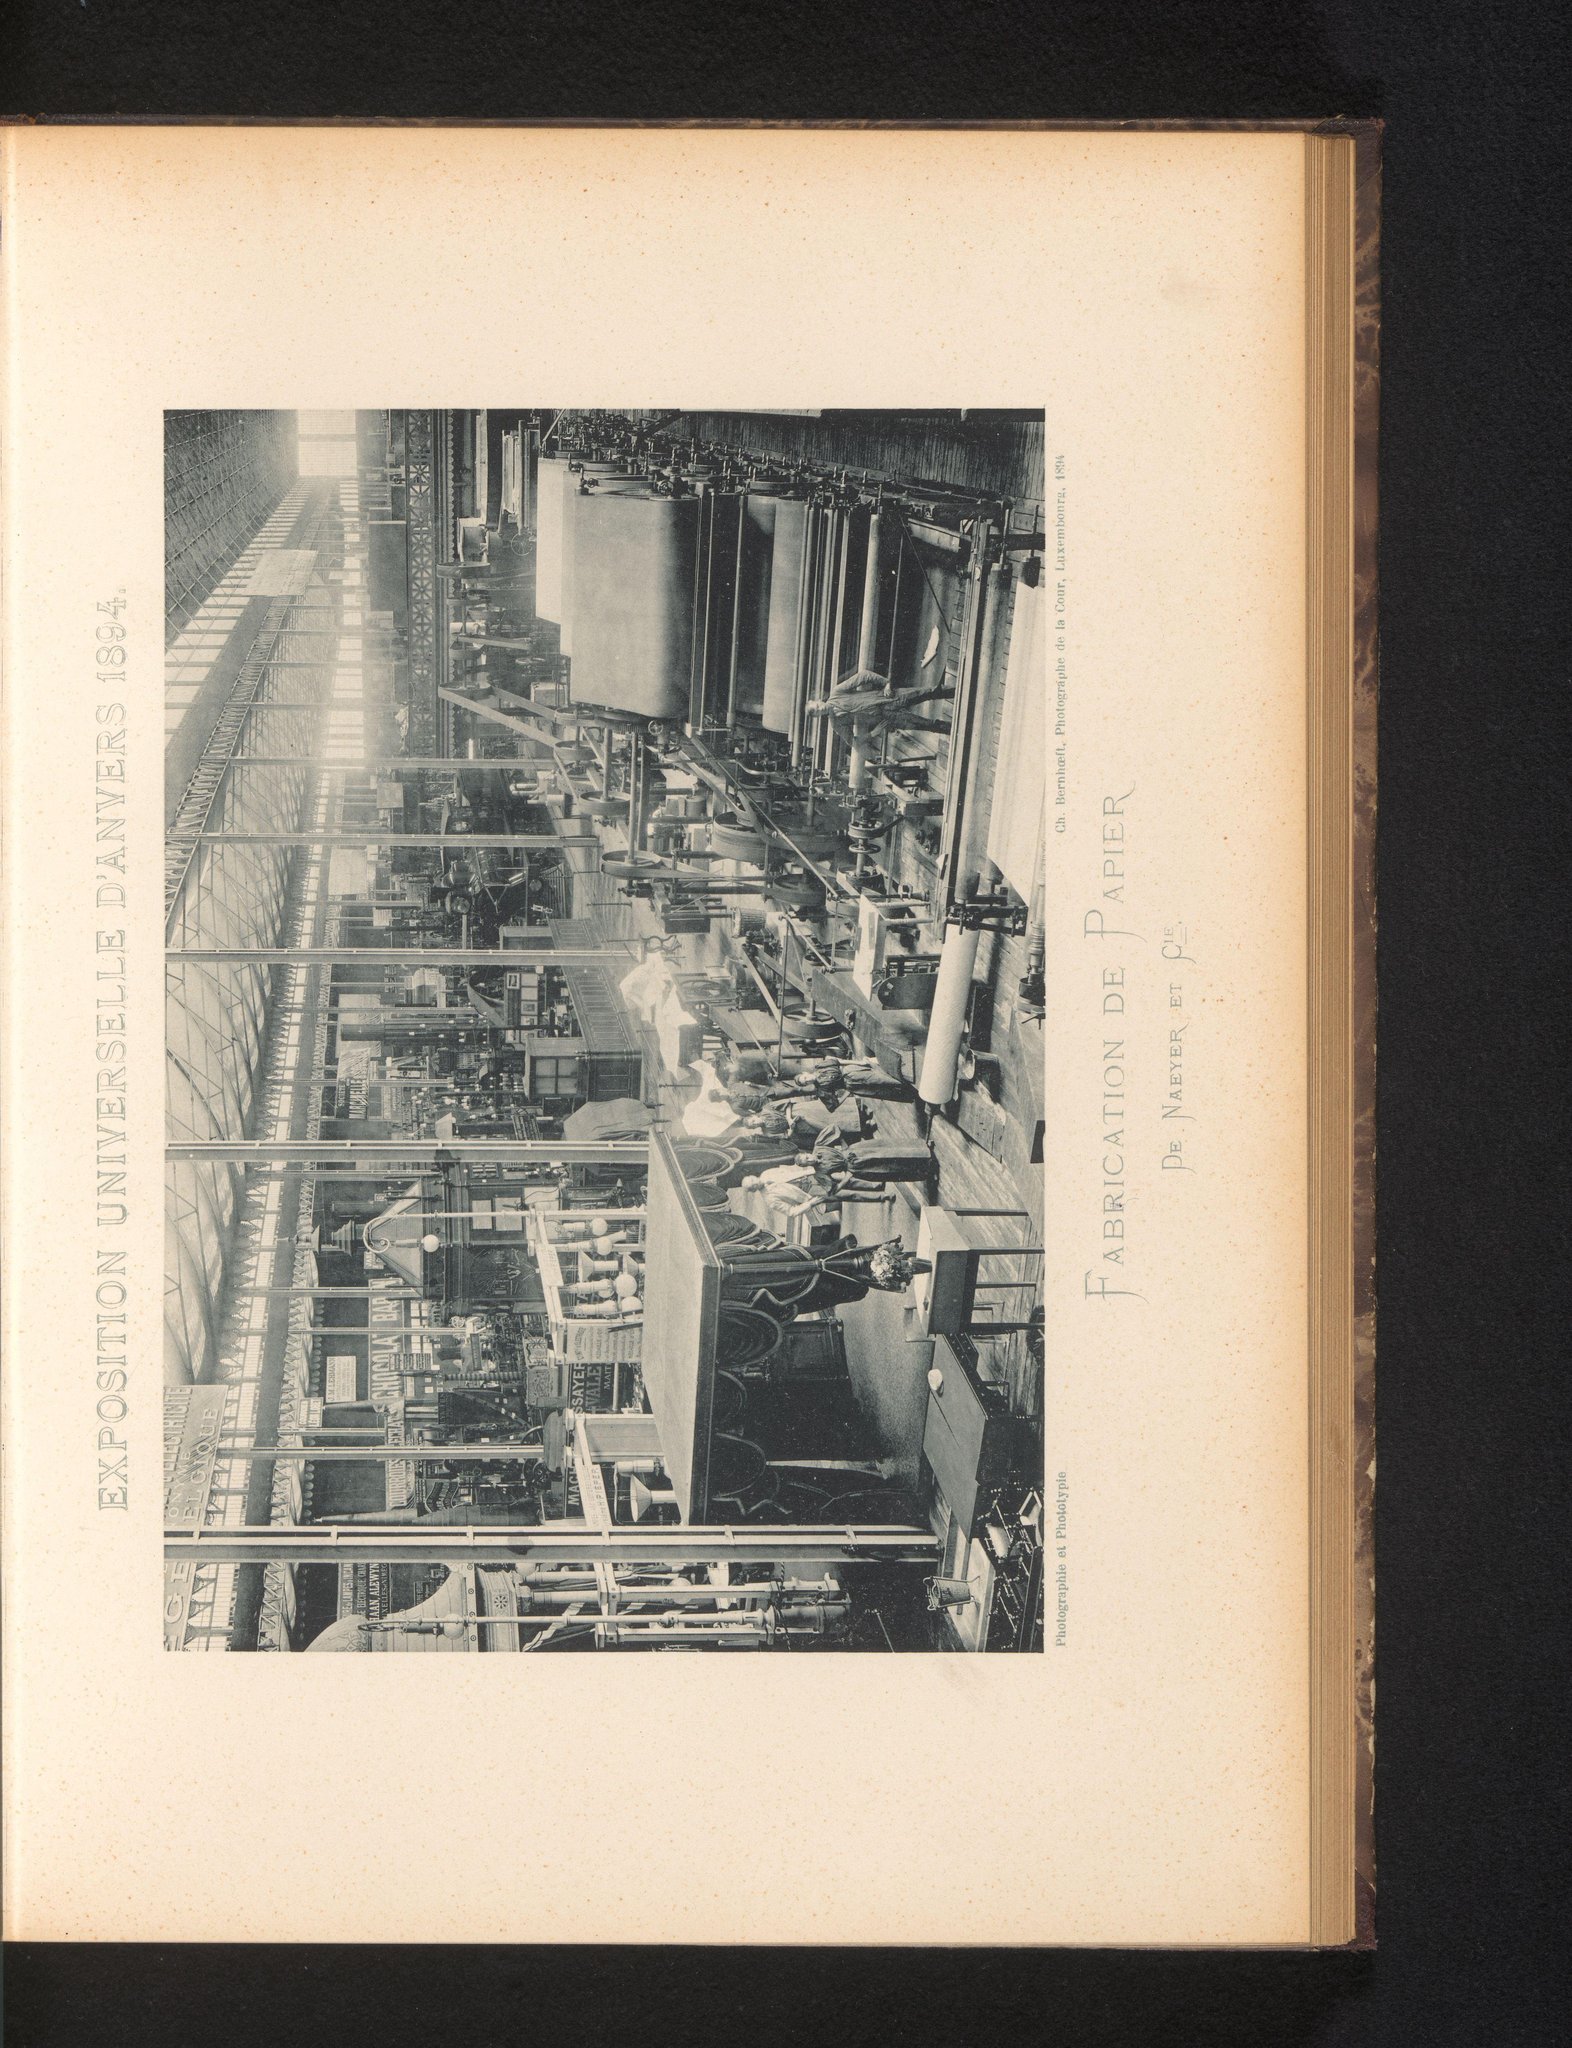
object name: page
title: Fabrication de Papier, De Naeyer et Cie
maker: charles bernhoeft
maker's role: publisher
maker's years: 1859-1933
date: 1894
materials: paper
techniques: photograph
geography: antwerp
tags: world fair, world exhibition, paper (writing material), workshop-interior, antwerp